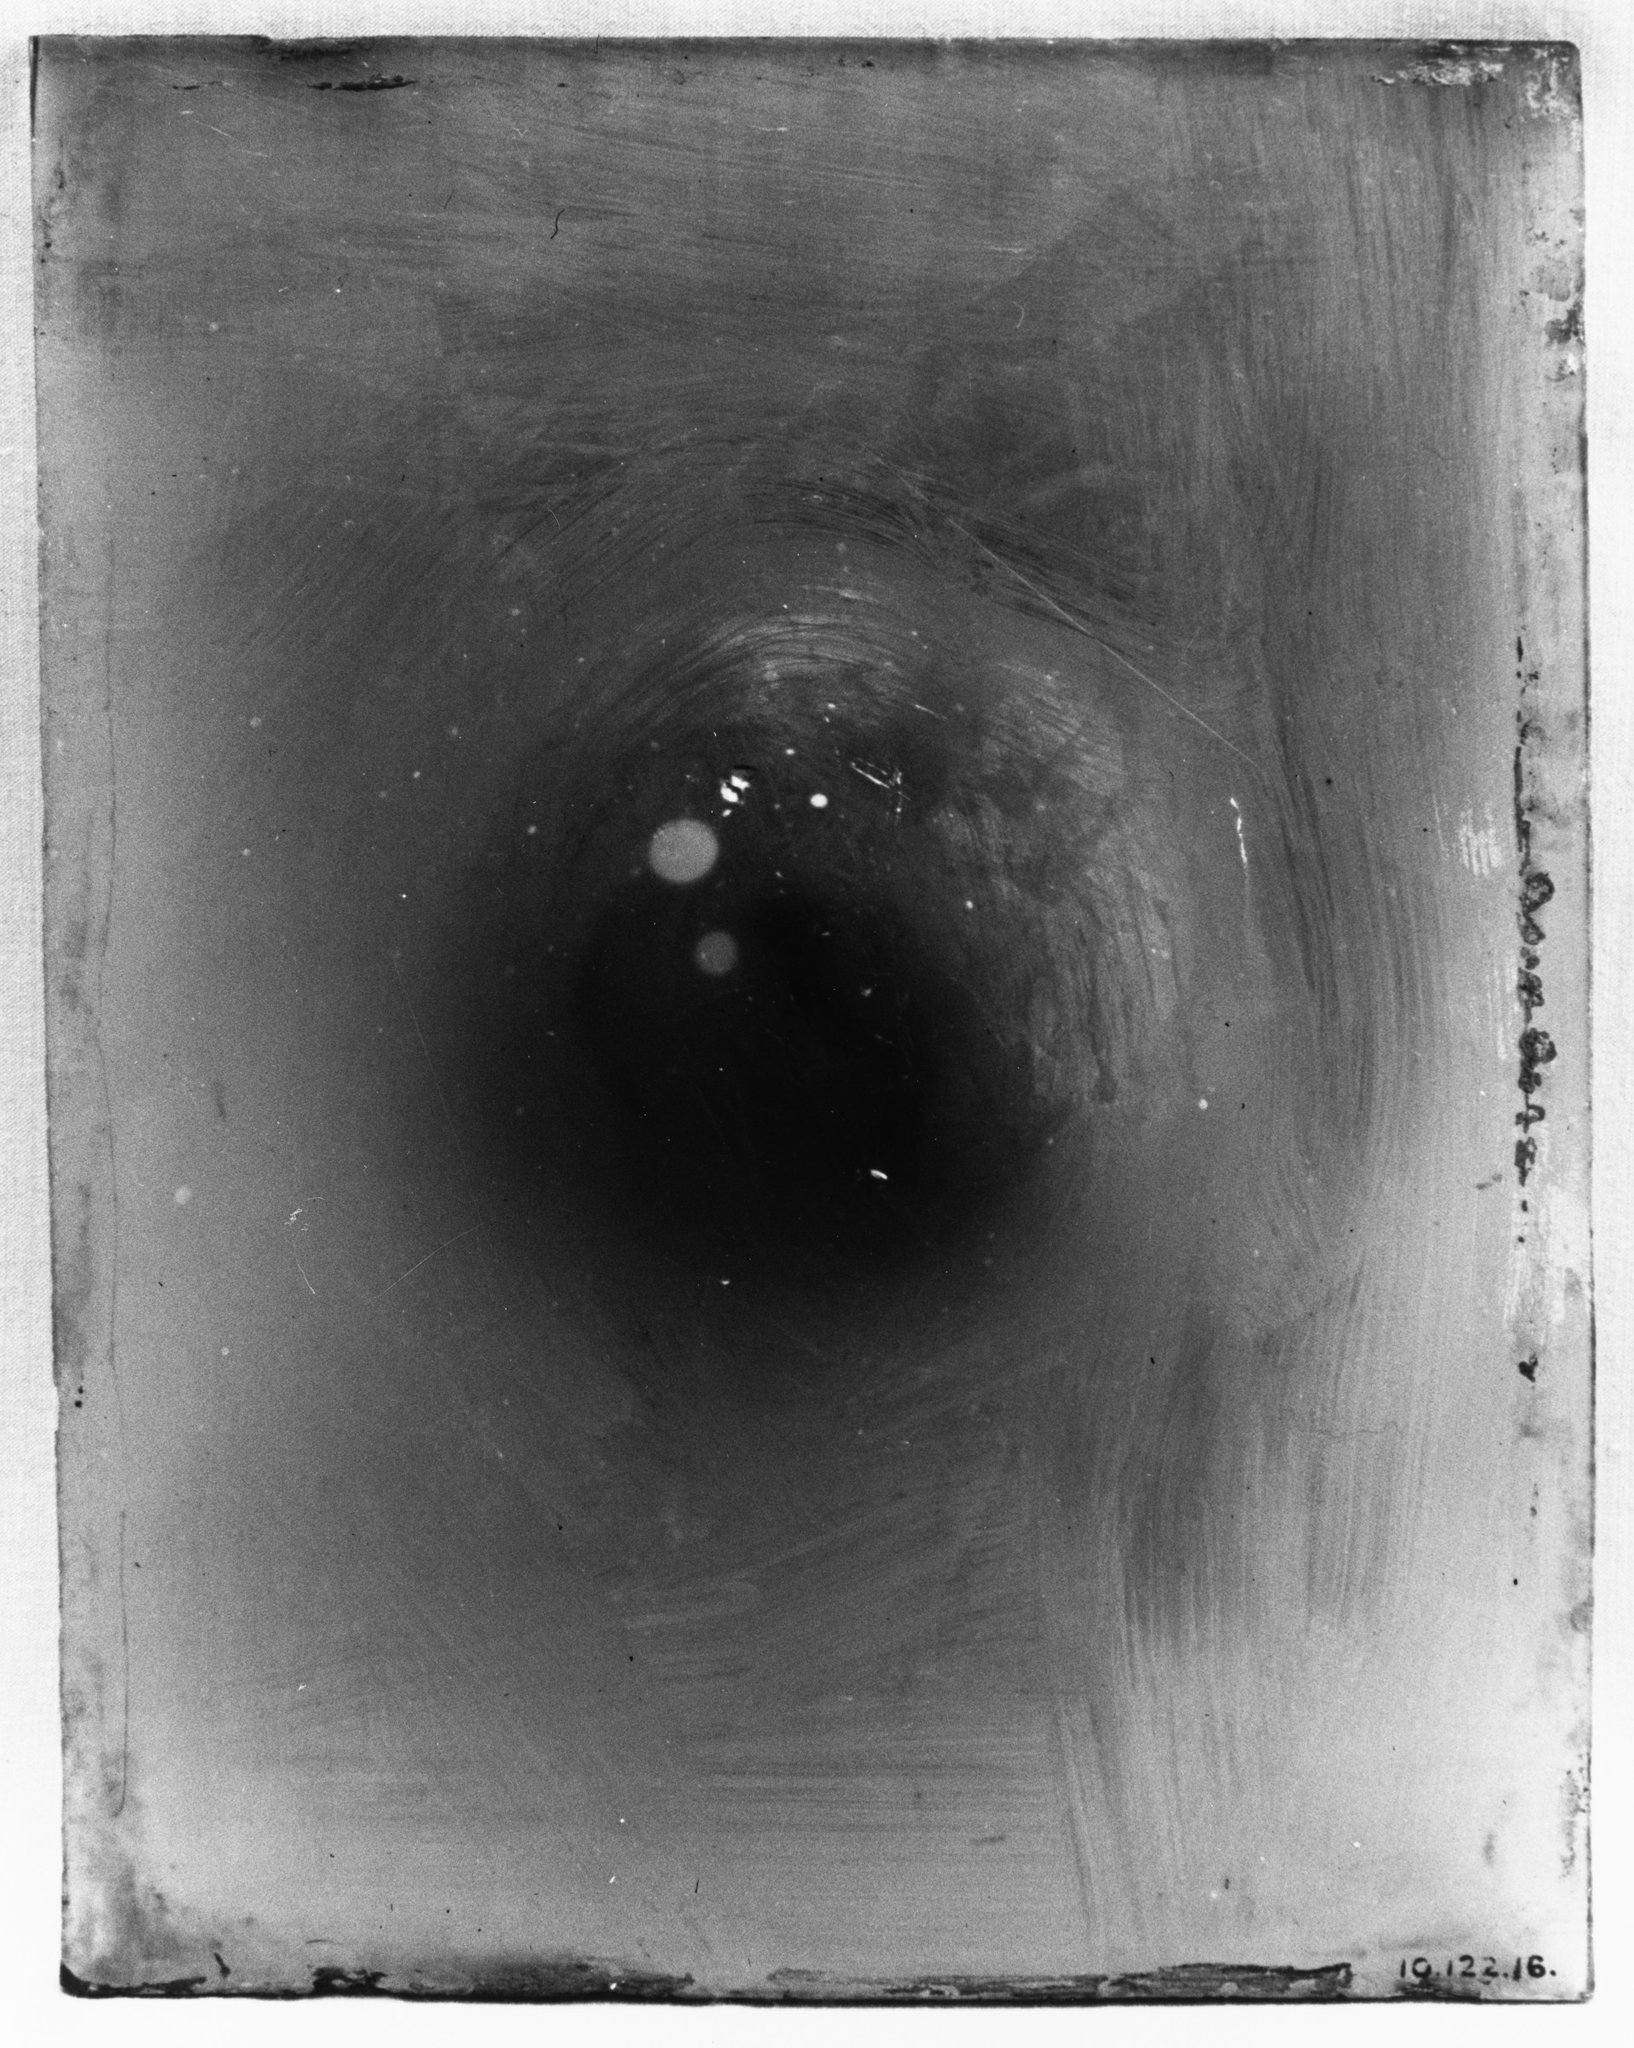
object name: windowpane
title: Bull's Eye Windowpane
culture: american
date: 1701-1800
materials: glass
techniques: glassblowing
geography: united states